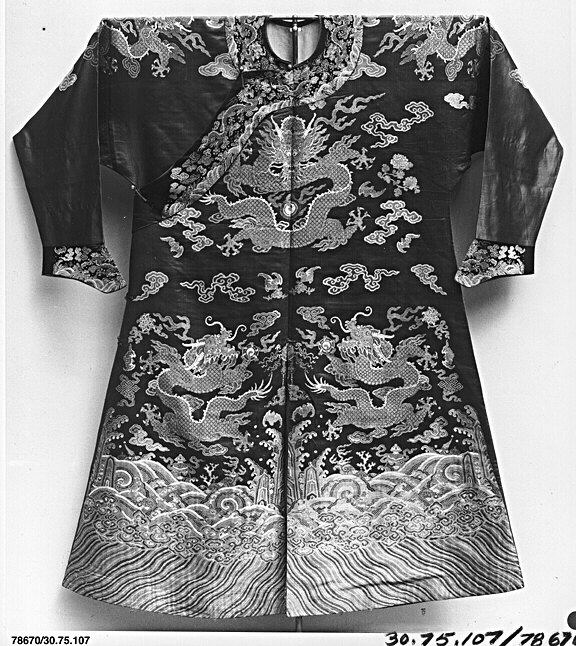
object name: robe, court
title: Court Robe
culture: chinese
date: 1701-1800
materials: metal thread, silk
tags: dragons